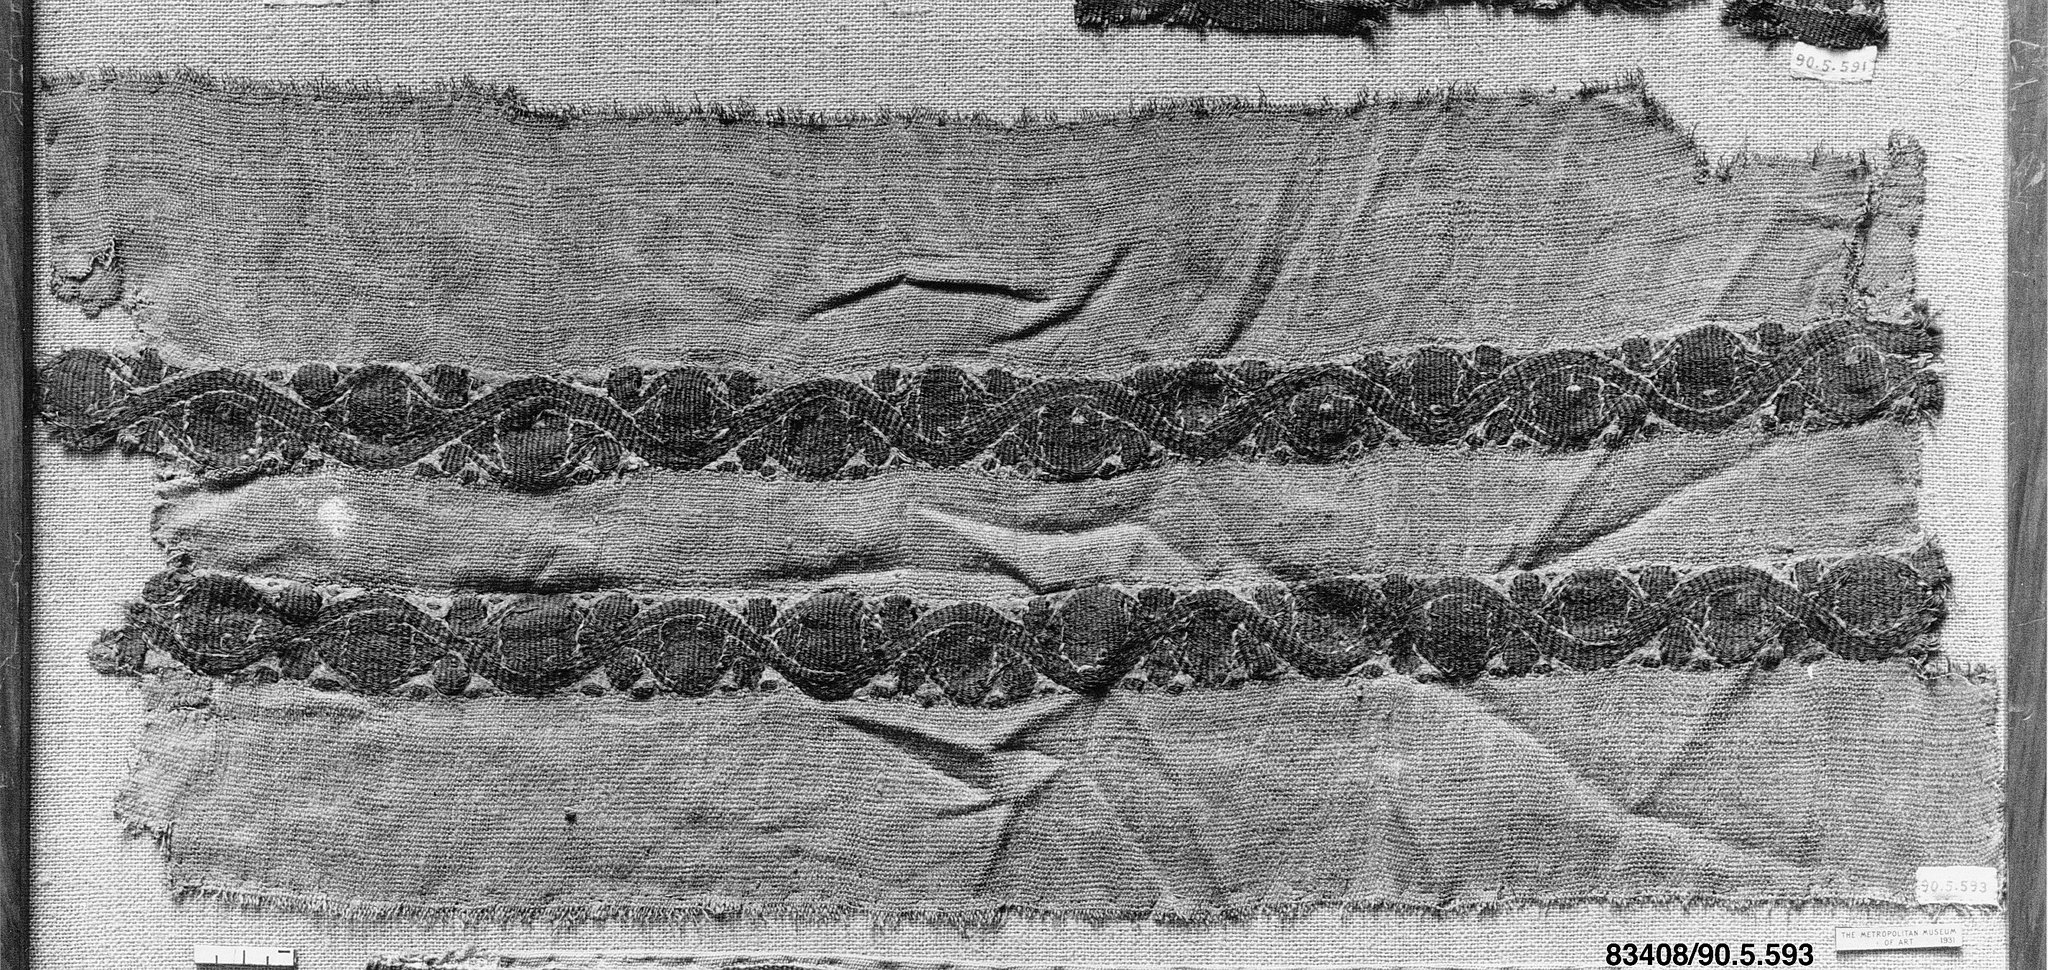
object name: textile fragment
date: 201-400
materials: linen, wool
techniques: weave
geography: egypt